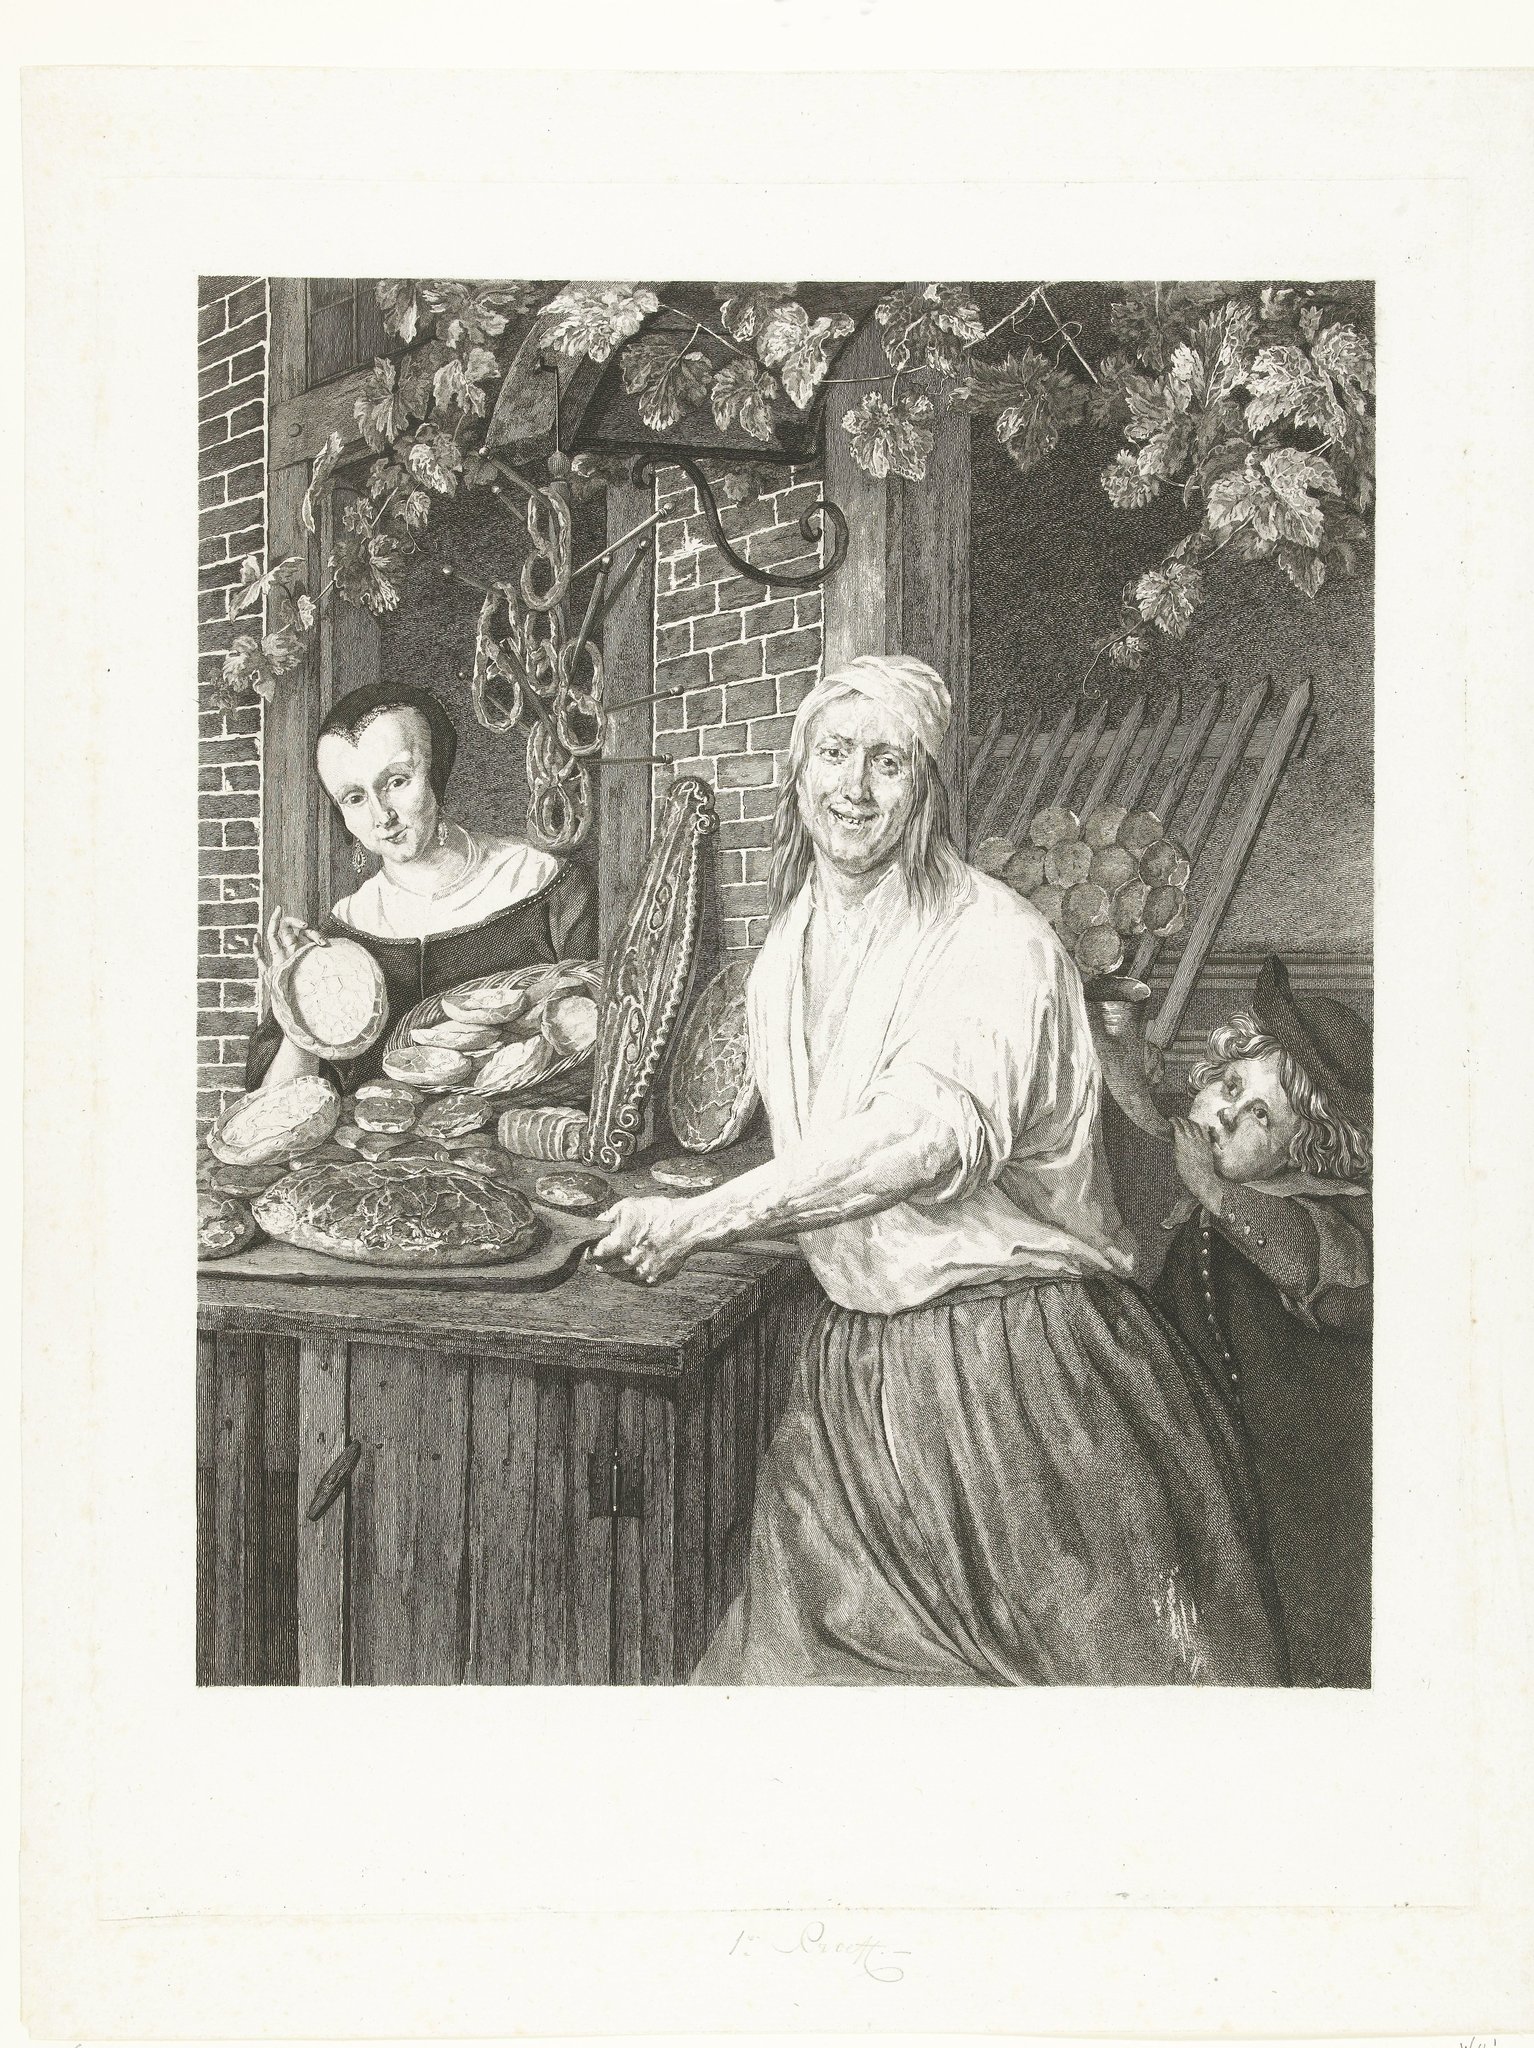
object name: print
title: Bakker Arent Oostwaard en zijn vrouw Catharina Keizerswaard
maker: joannes bemme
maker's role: print maker, printer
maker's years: 1775-1841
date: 1800-1841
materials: paper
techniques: etching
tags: historical persons - bb - woman, historical persons, bread, loaf, hornblowing baker (+ variant), baker, hornblowing baker, baker (+ outdoors; in the open air), leiden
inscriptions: collector's mark: Lugt 2228, inscription: ‘1e proeff’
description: Portret van het Leidse bakkersechtpaar Arent Oostwaard (Arend Oostwaert) en Catharina Keizerswaard (Catharina Keyzerswaert) met allerlei verschillende soorten vers gebakken brood (broodjes, krakelingen, kadetten, duivekater) voor de bakkerij. In de deur van de bakkerij blaast een jongetje op een hoorn, om mensen te laten weten dat het brood klaar is. Volgens een opschrift op de achterzijde van het schilderij van Jan Steen gaat het hier om het zoontje van de schilder, Thaddeus, op 7-jarige leeftijd. Boven de deur groeien wijnranken.